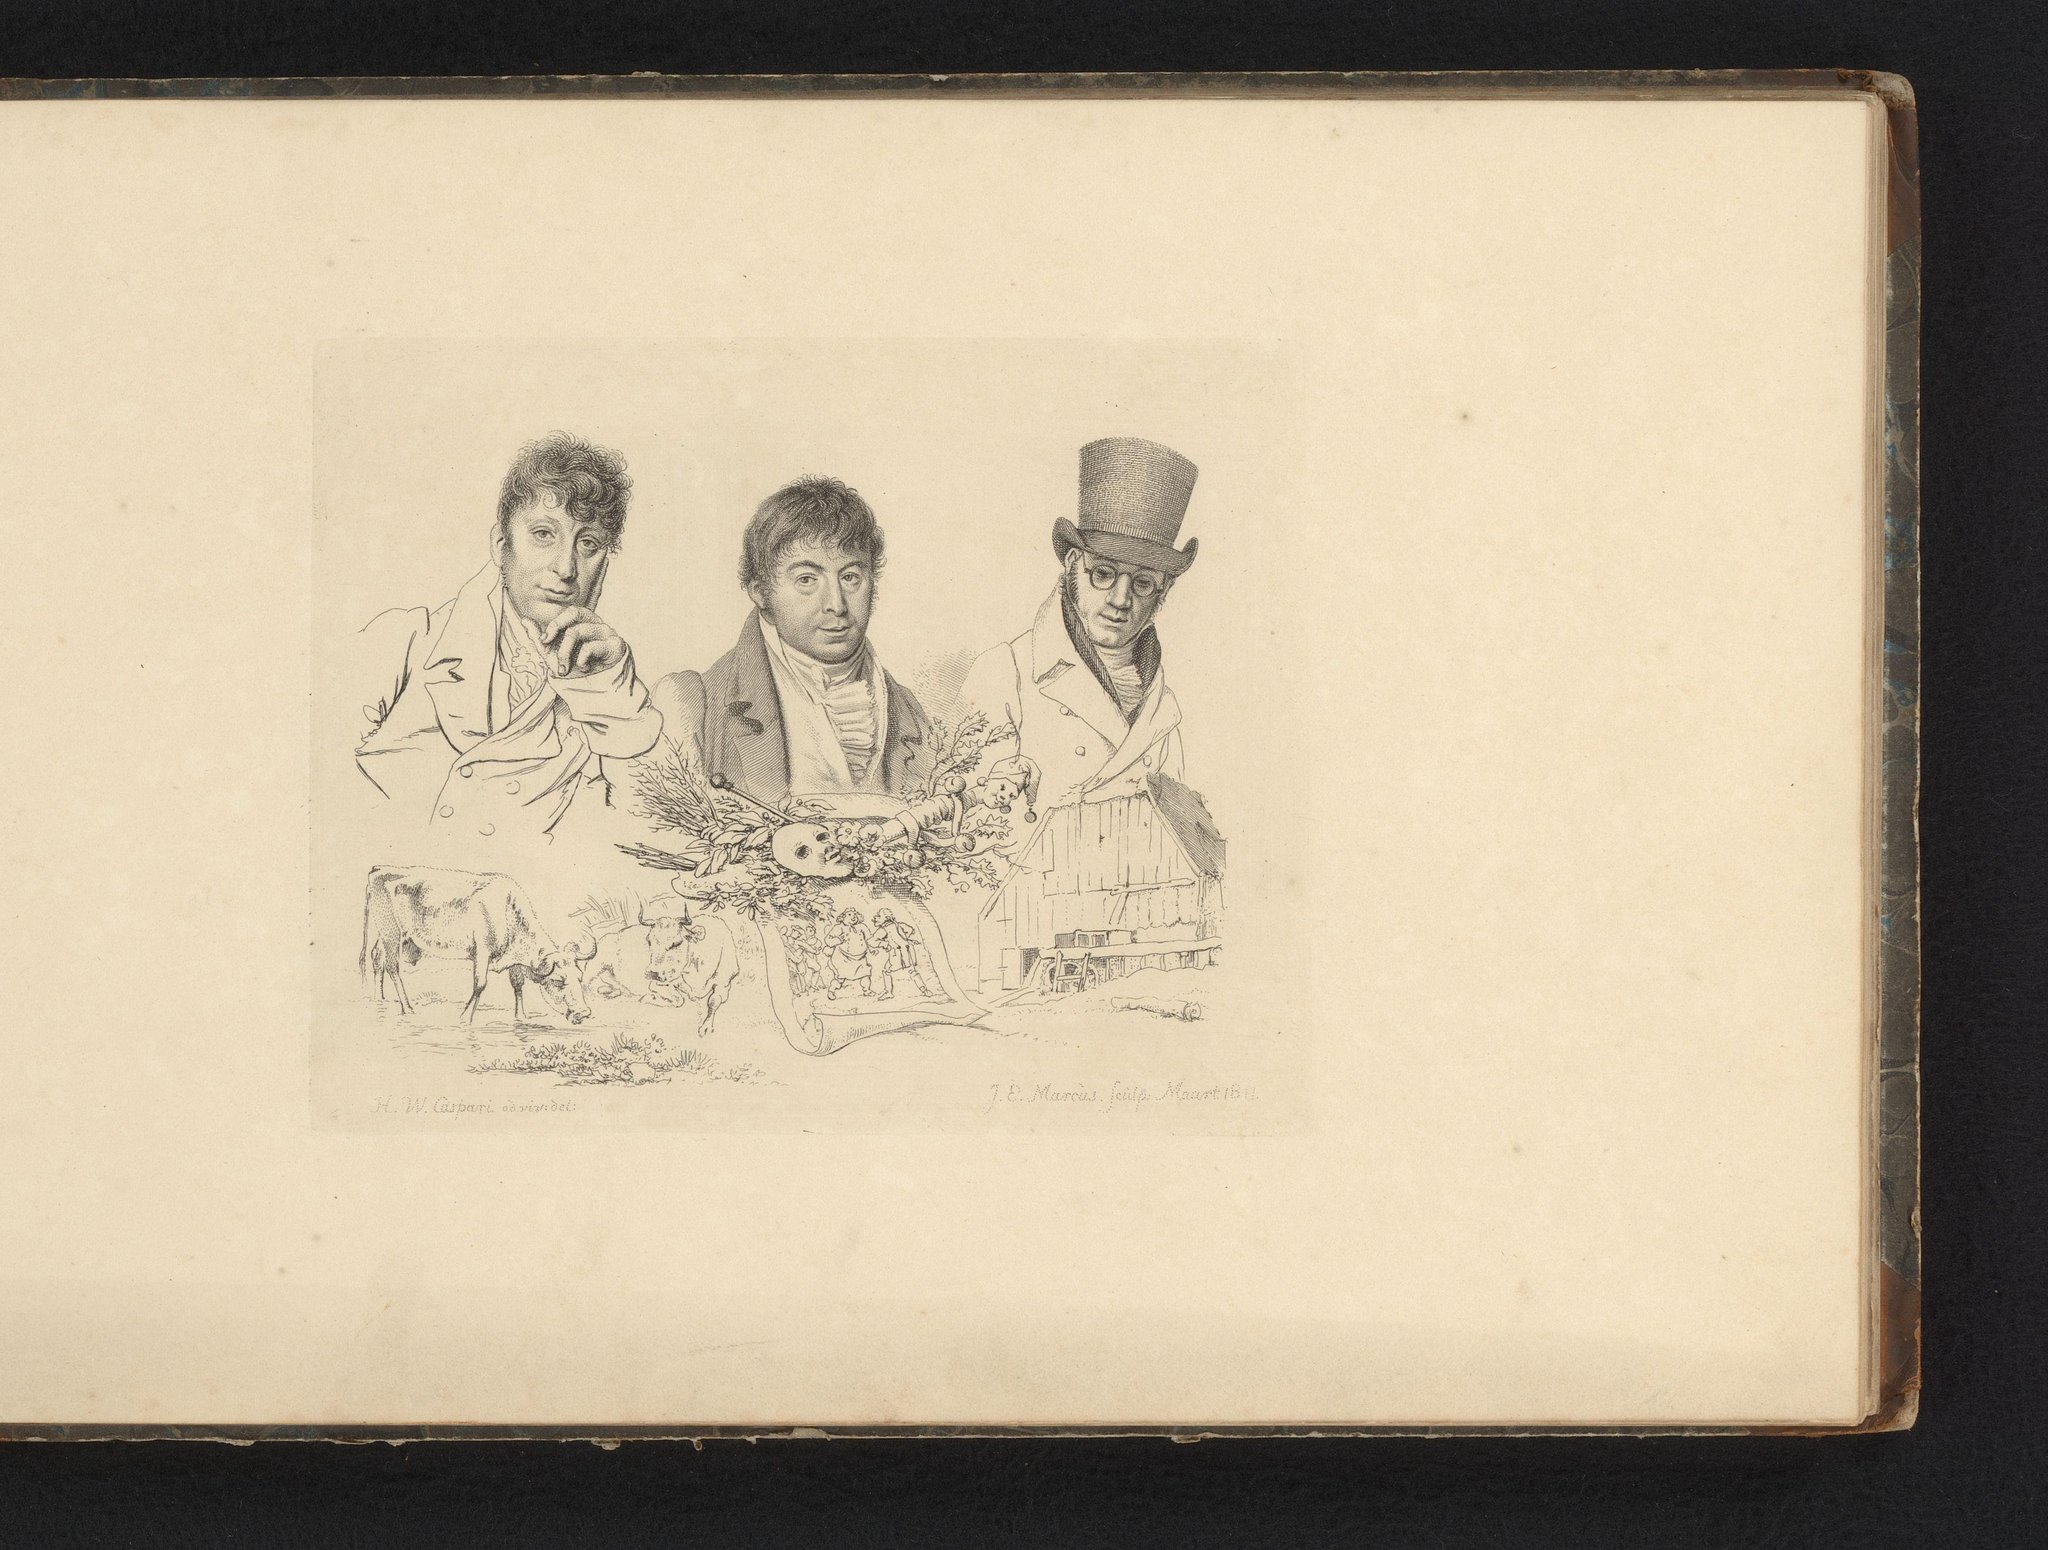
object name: album leaf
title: Studiebeelden en fragmenten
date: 1803-1811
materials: paper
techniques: etching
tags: daniël kerkhoff, jacob smies, amsterdam, painter, draughtsman, hendrik stokvisch, barn, drawing, sketch, cow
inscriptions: date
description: Portretten van de kunstenaars Hendrik Stokvisch, Jacob Smies en Daniël Kerkhoff. Onder elk portret een op de kunstenaar betrekking hebbend motief, respectievelijk koeien in een weide, een tekening met een komische voorstelling en een boerenschuur. Deze prent maakt deel uit van een album.